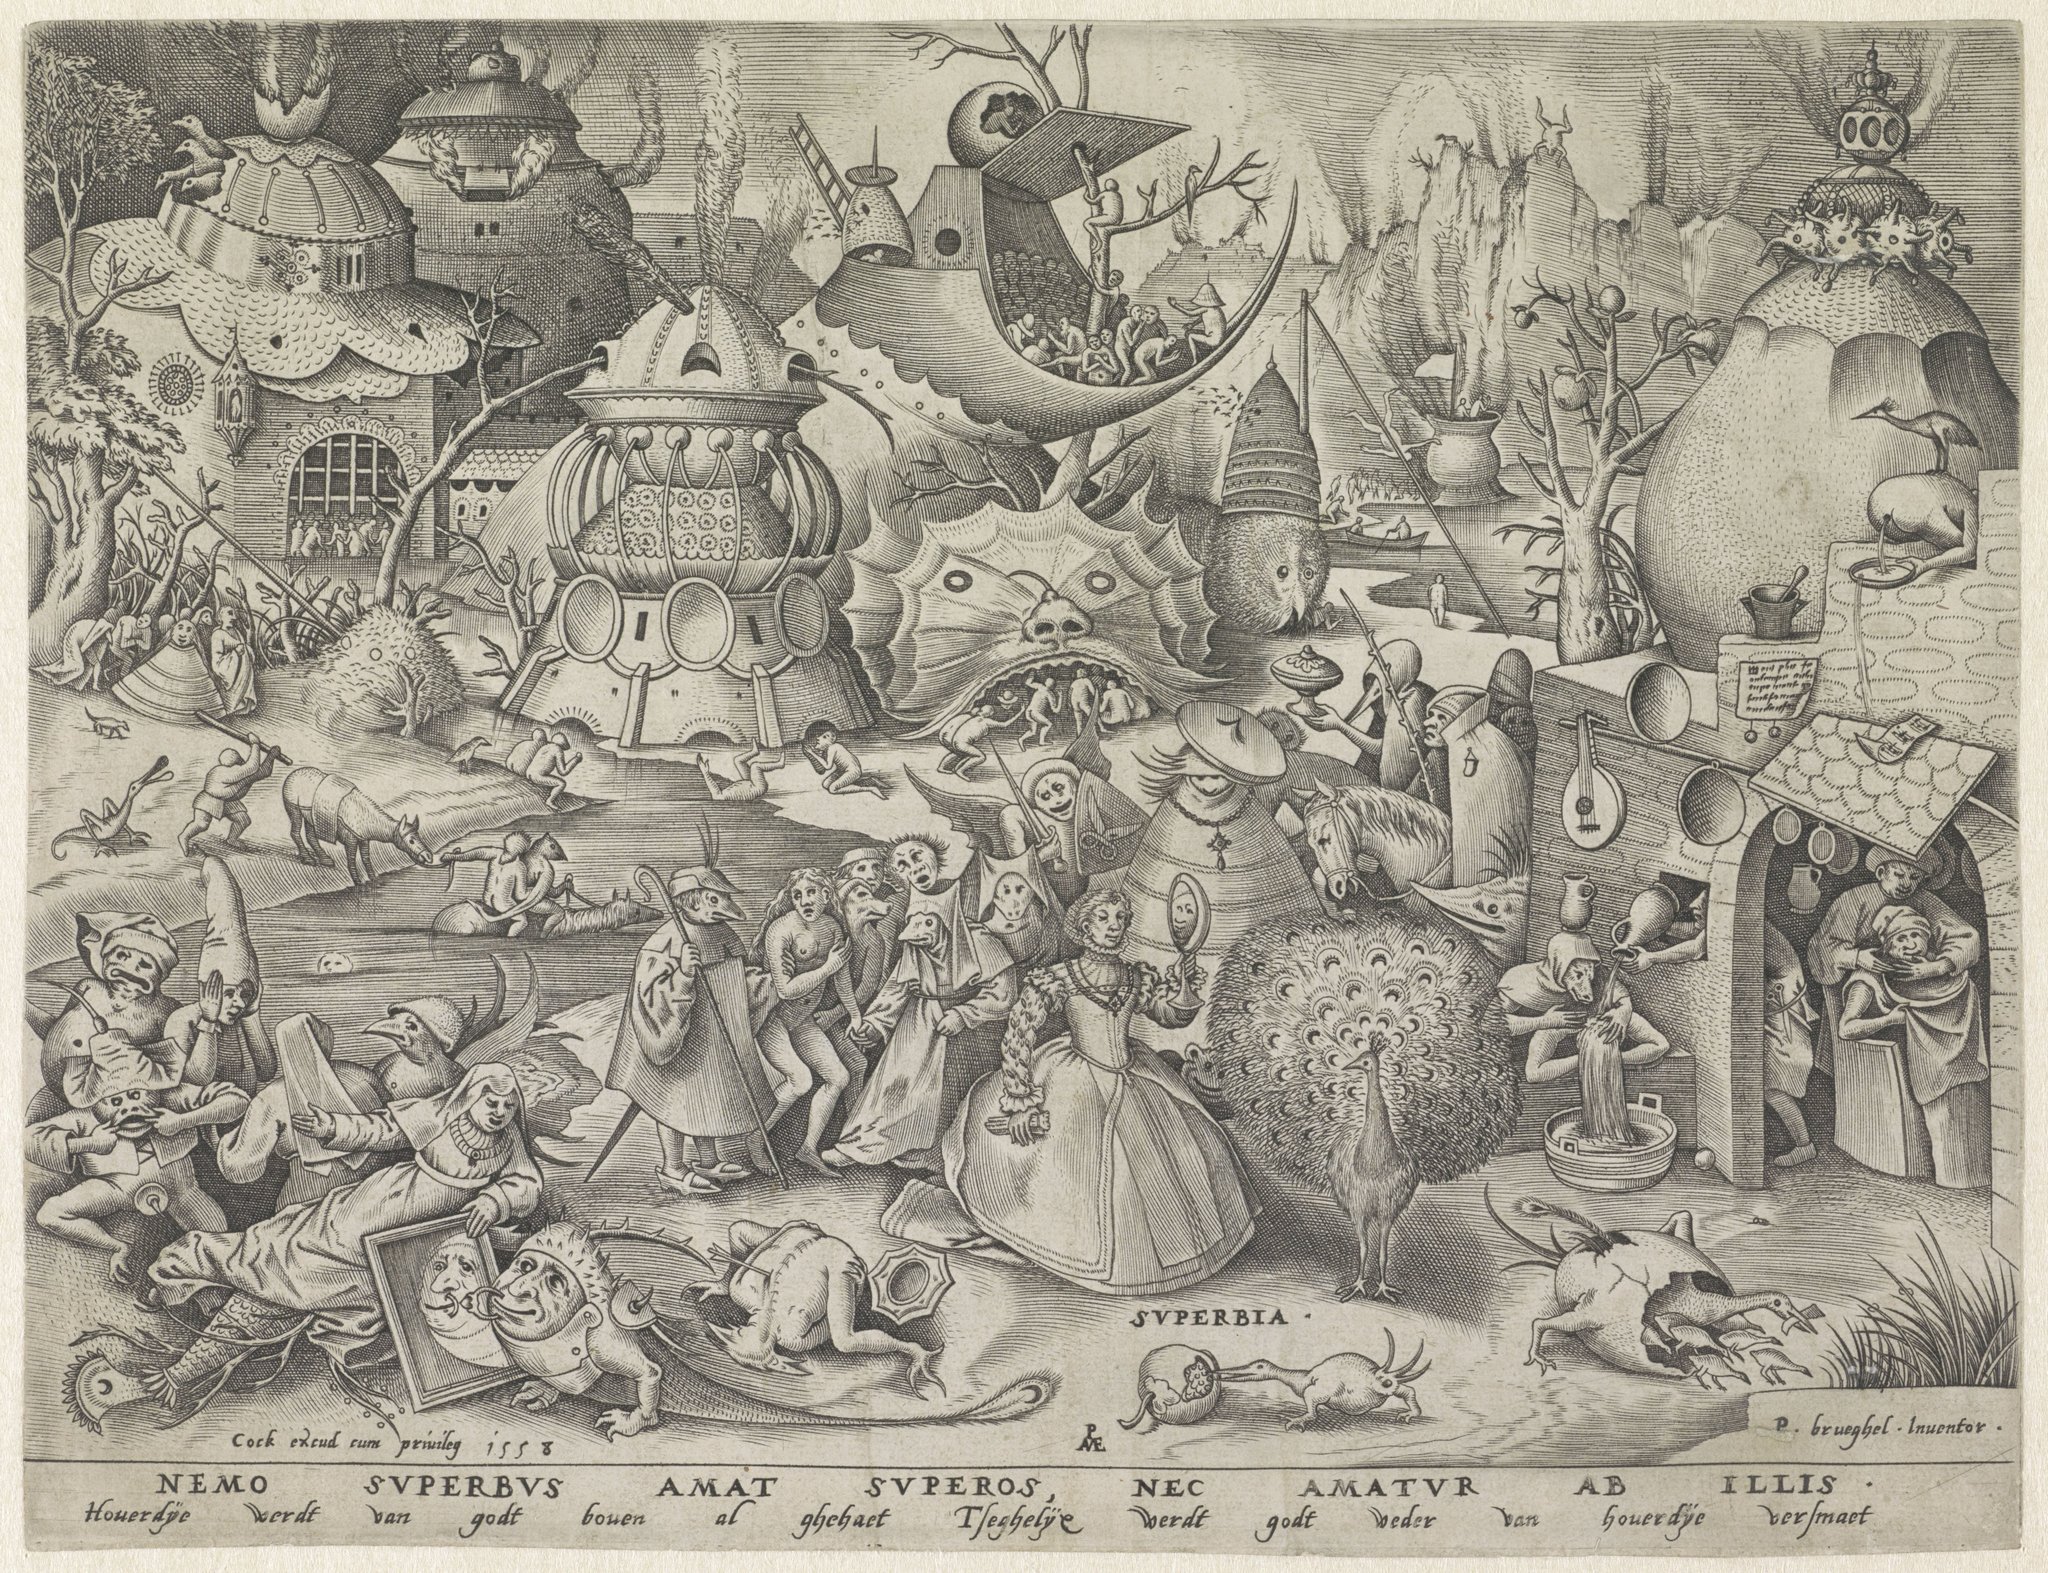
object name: print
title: De zeven hoofdzonden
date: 1558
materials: paper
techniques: engraving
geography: antwerp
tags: mirror, pride; 'superbia' (ripa) ~ personification of one of the seven deadly sins, care of the hair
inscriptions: collector's mark: Lugt 2228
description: Vrouwelijke personificatie van de Hoogmoed (Superbia) in rijk gewaad met spiegel in de hand, staande naast een pauw. Hieromheen allerlei fantastische scènes en gedrochten waarmee deze hoofdzonde wordt uitgebeeld. Met onderschrift van een regel in het Latijn en een regel in het Nederlands.